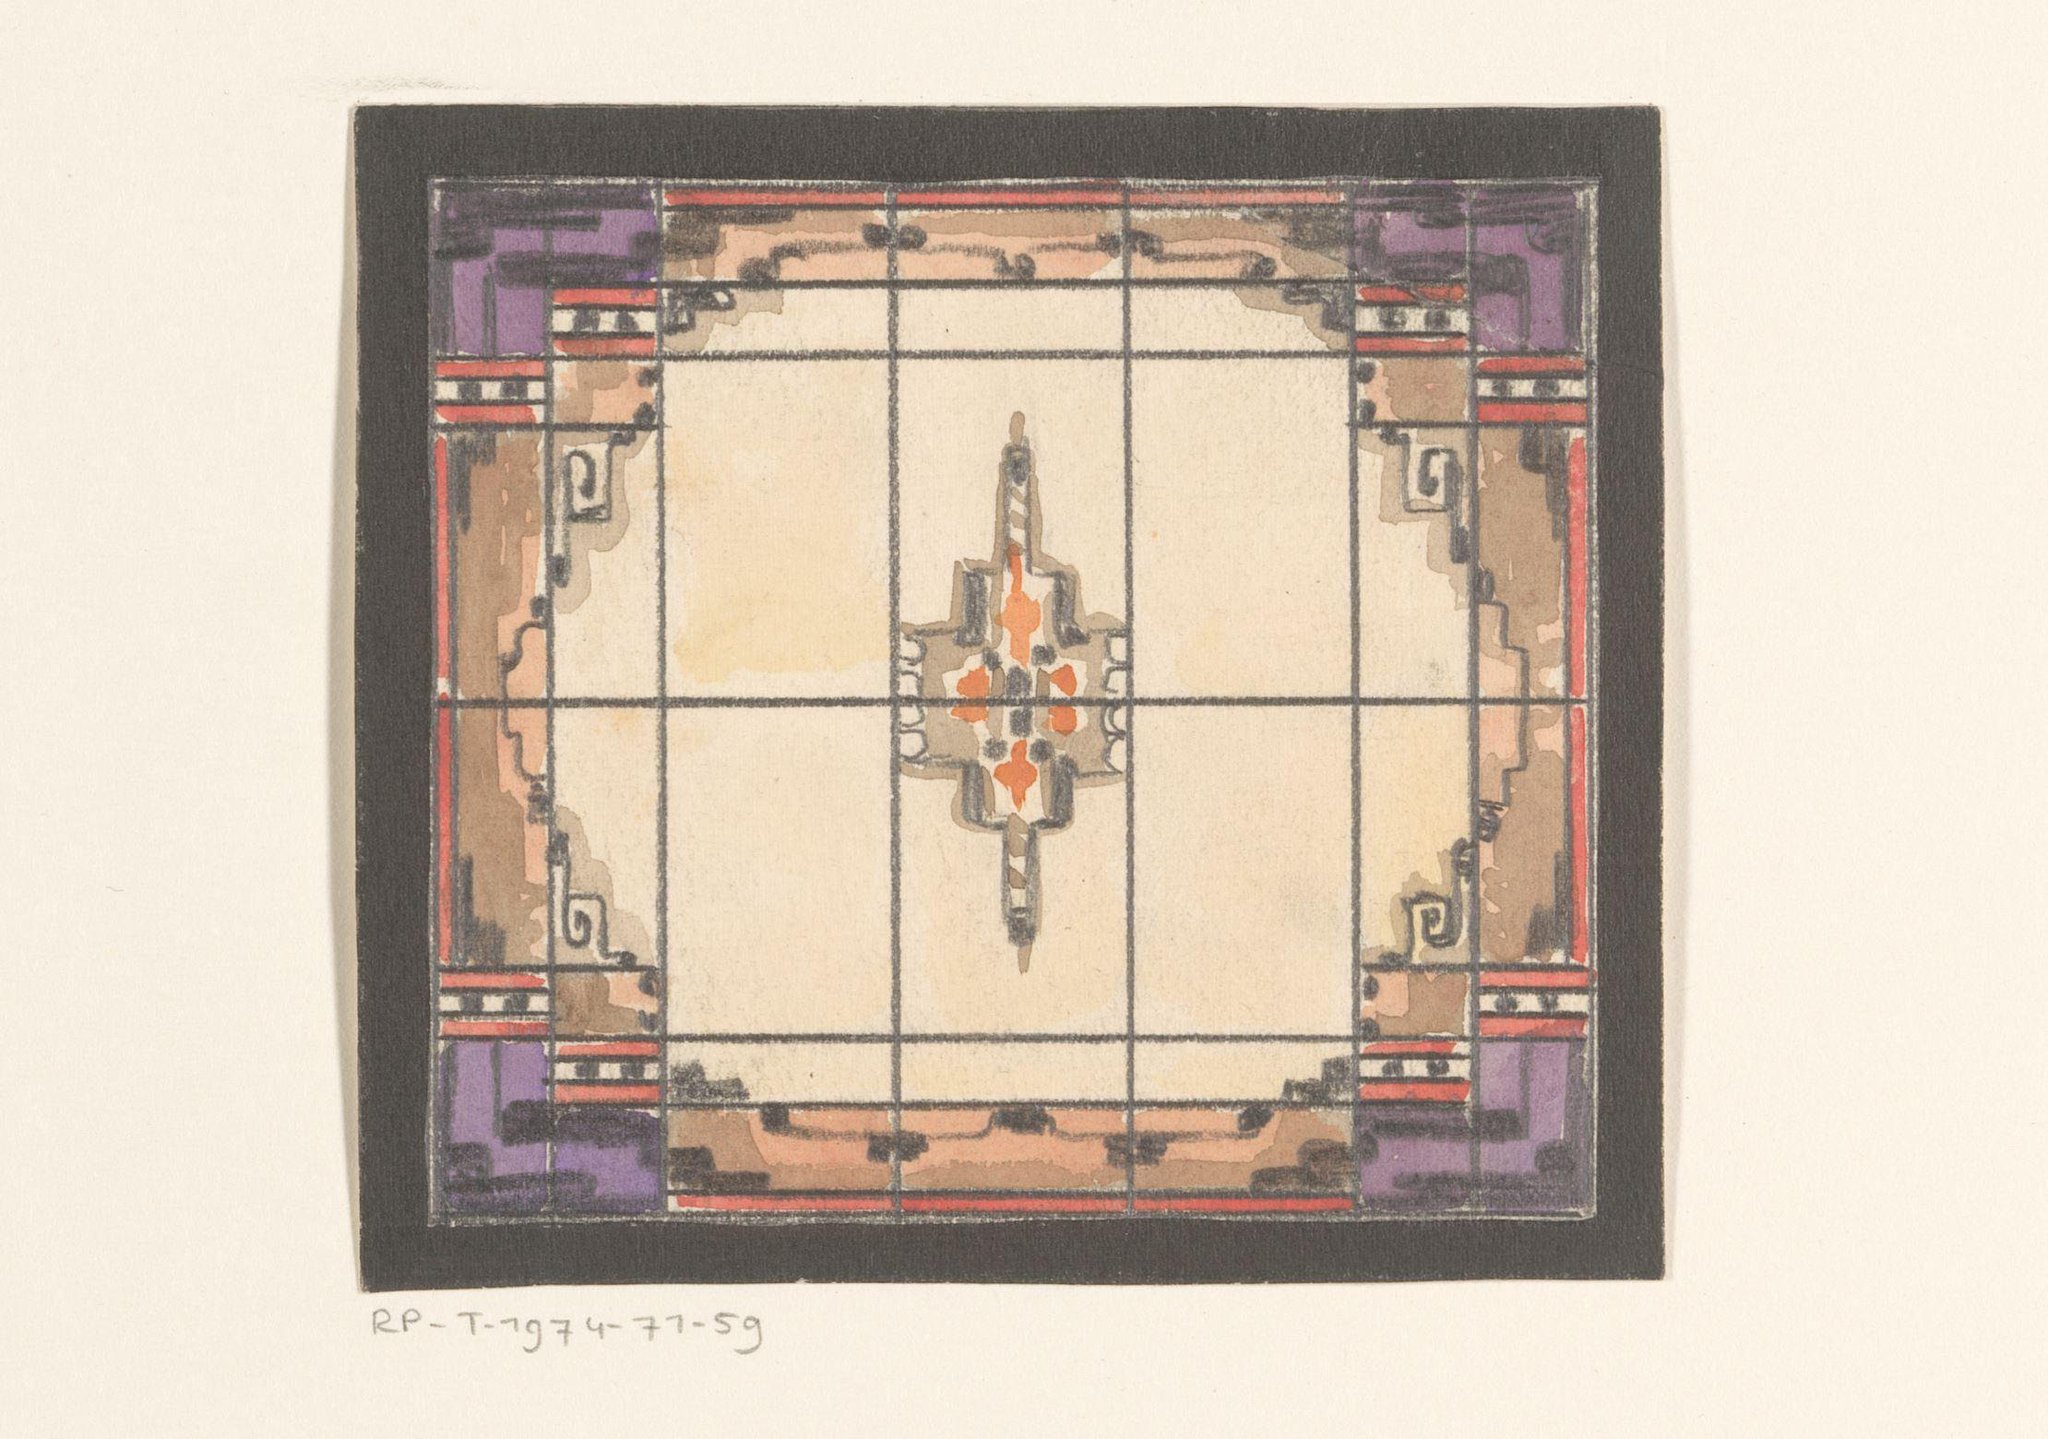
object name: design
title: Ontwerp voor een glas in loodraam met rechthoeken en een stervorm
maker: Anonymous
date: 1907-1930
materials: ink, paper, pencil, watercolor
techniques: brush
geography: amsterdam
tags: ornaments ~ art